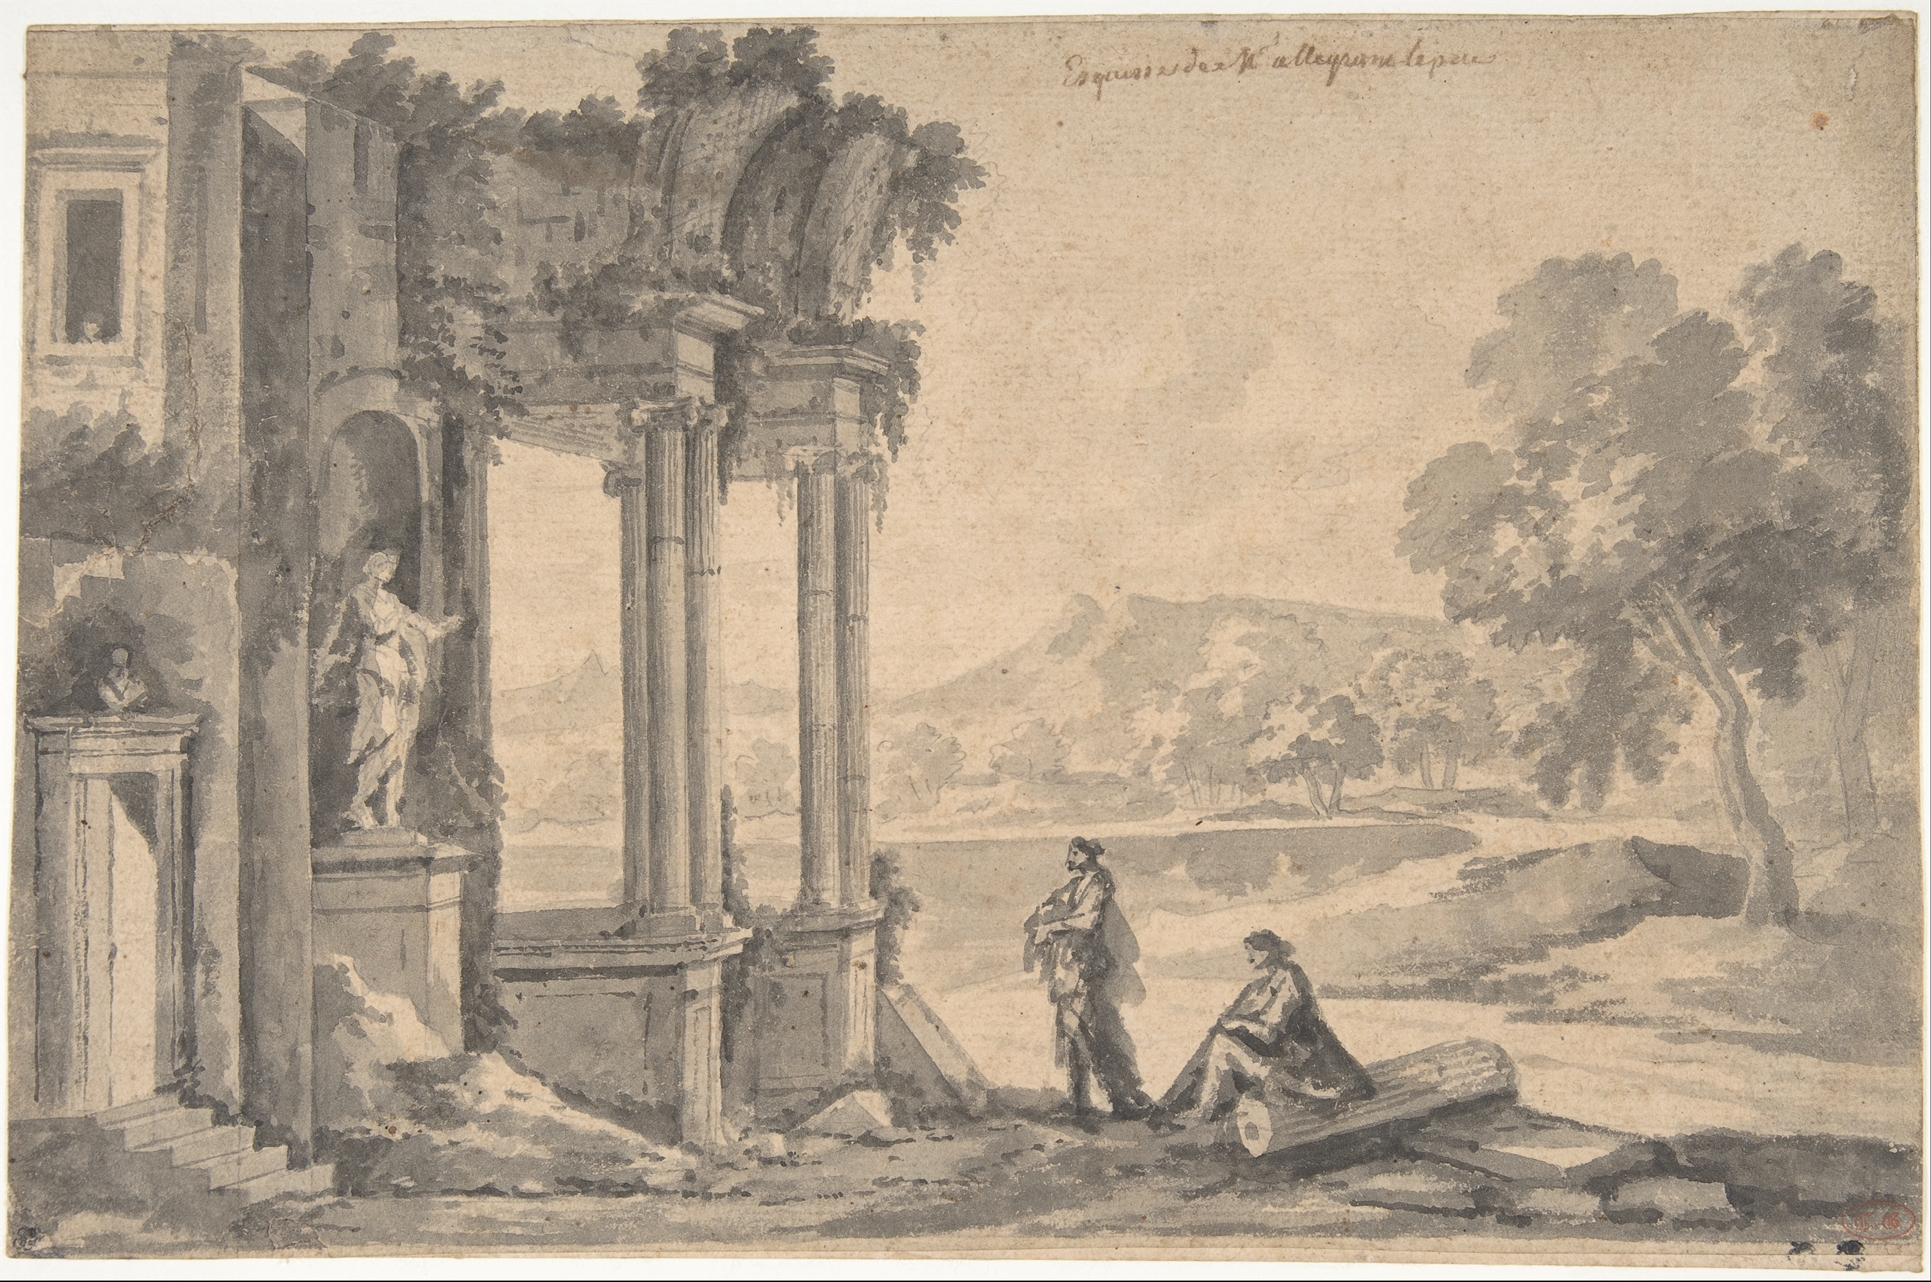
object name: drawing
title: Ruins of a Temple by a Lake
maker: etienne allegrain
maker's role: artist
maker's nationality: french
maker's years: 1644-1736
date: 1644-1736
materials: graphite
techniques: brush, wash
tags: temples,ruins,men,lakes,trees